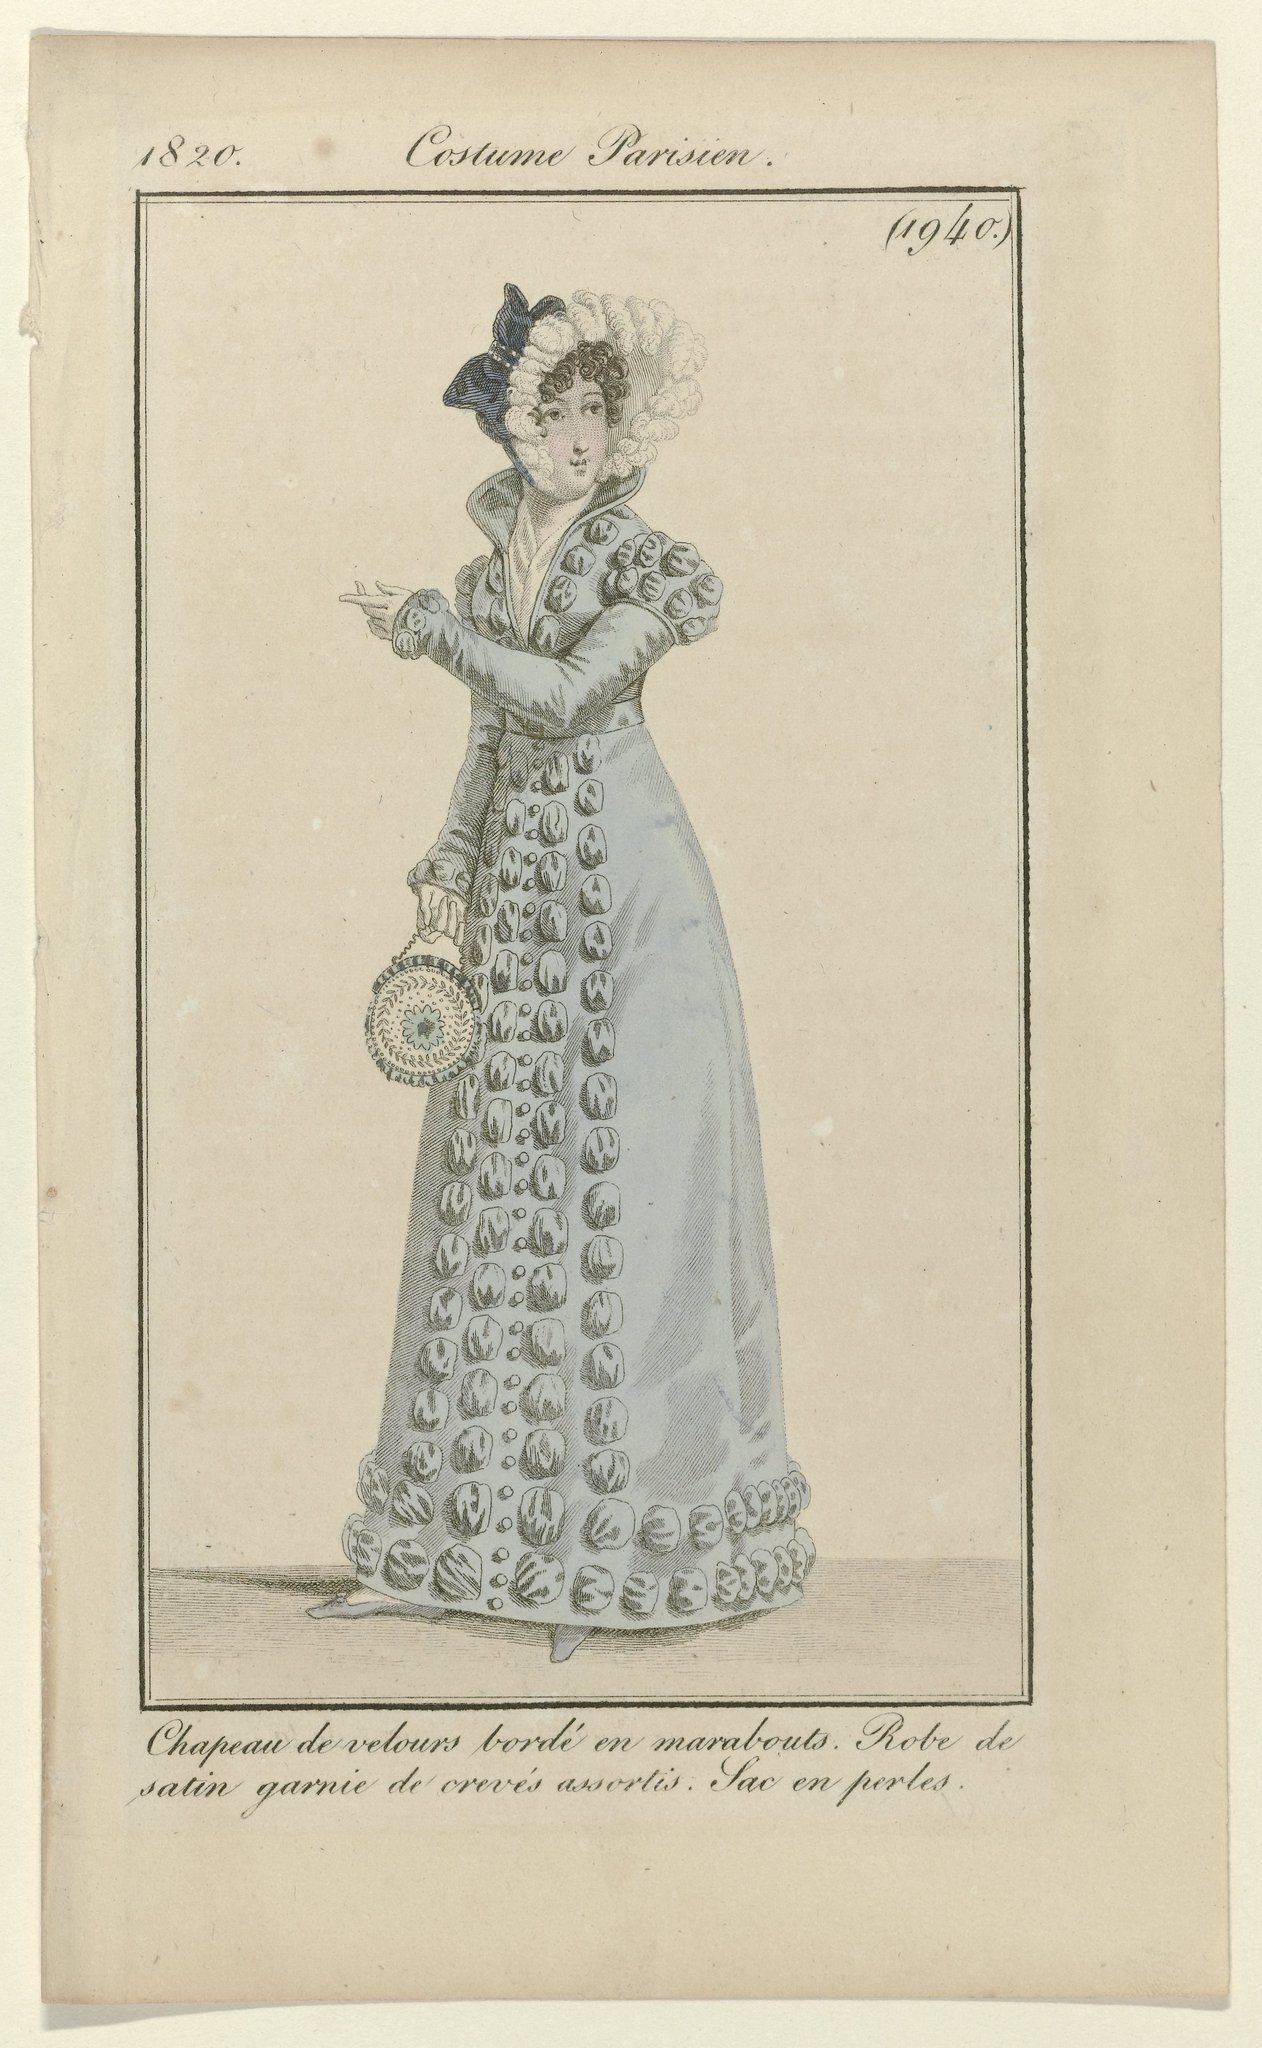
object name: fashion print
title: Journal des Dames et des Modes, Costume Parisien, 10 novembre 1820, (1940): Chapeau de velours (...)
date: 1820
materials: paper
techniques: engraving, hand coloring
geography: paris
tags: ornamental parts of clothing (+ women's clothes), bag (handbag) (+ women's clothes), border, ribbon, braid (+ feathers used for clothes), fashion plates, head-gear: hat (+ women's clothes), shoes, sandals (+ women's clothes), dress, gown (+ women's clothes)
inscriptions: title: ‘Costume Parisien.’, caption: ‘Chapeau de velours bordé en marabouts. Robe de satin garnie de crevés assortis. Sac en perles.’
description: Staande vrouw gekleed in een japon van satijn, gegarneerd met 'crevés assortis'. Op het hoofd een hoed van fluweel afgezet met maraboeveren. Tasje met parels in de rechterhand. platte schoenen met strikken. De prent maakt deel uit van het modetijdschrift Journal des Dames et des Modes, uitgegeven door Pierre de la Mésangère, Parijs, 1797-1839.